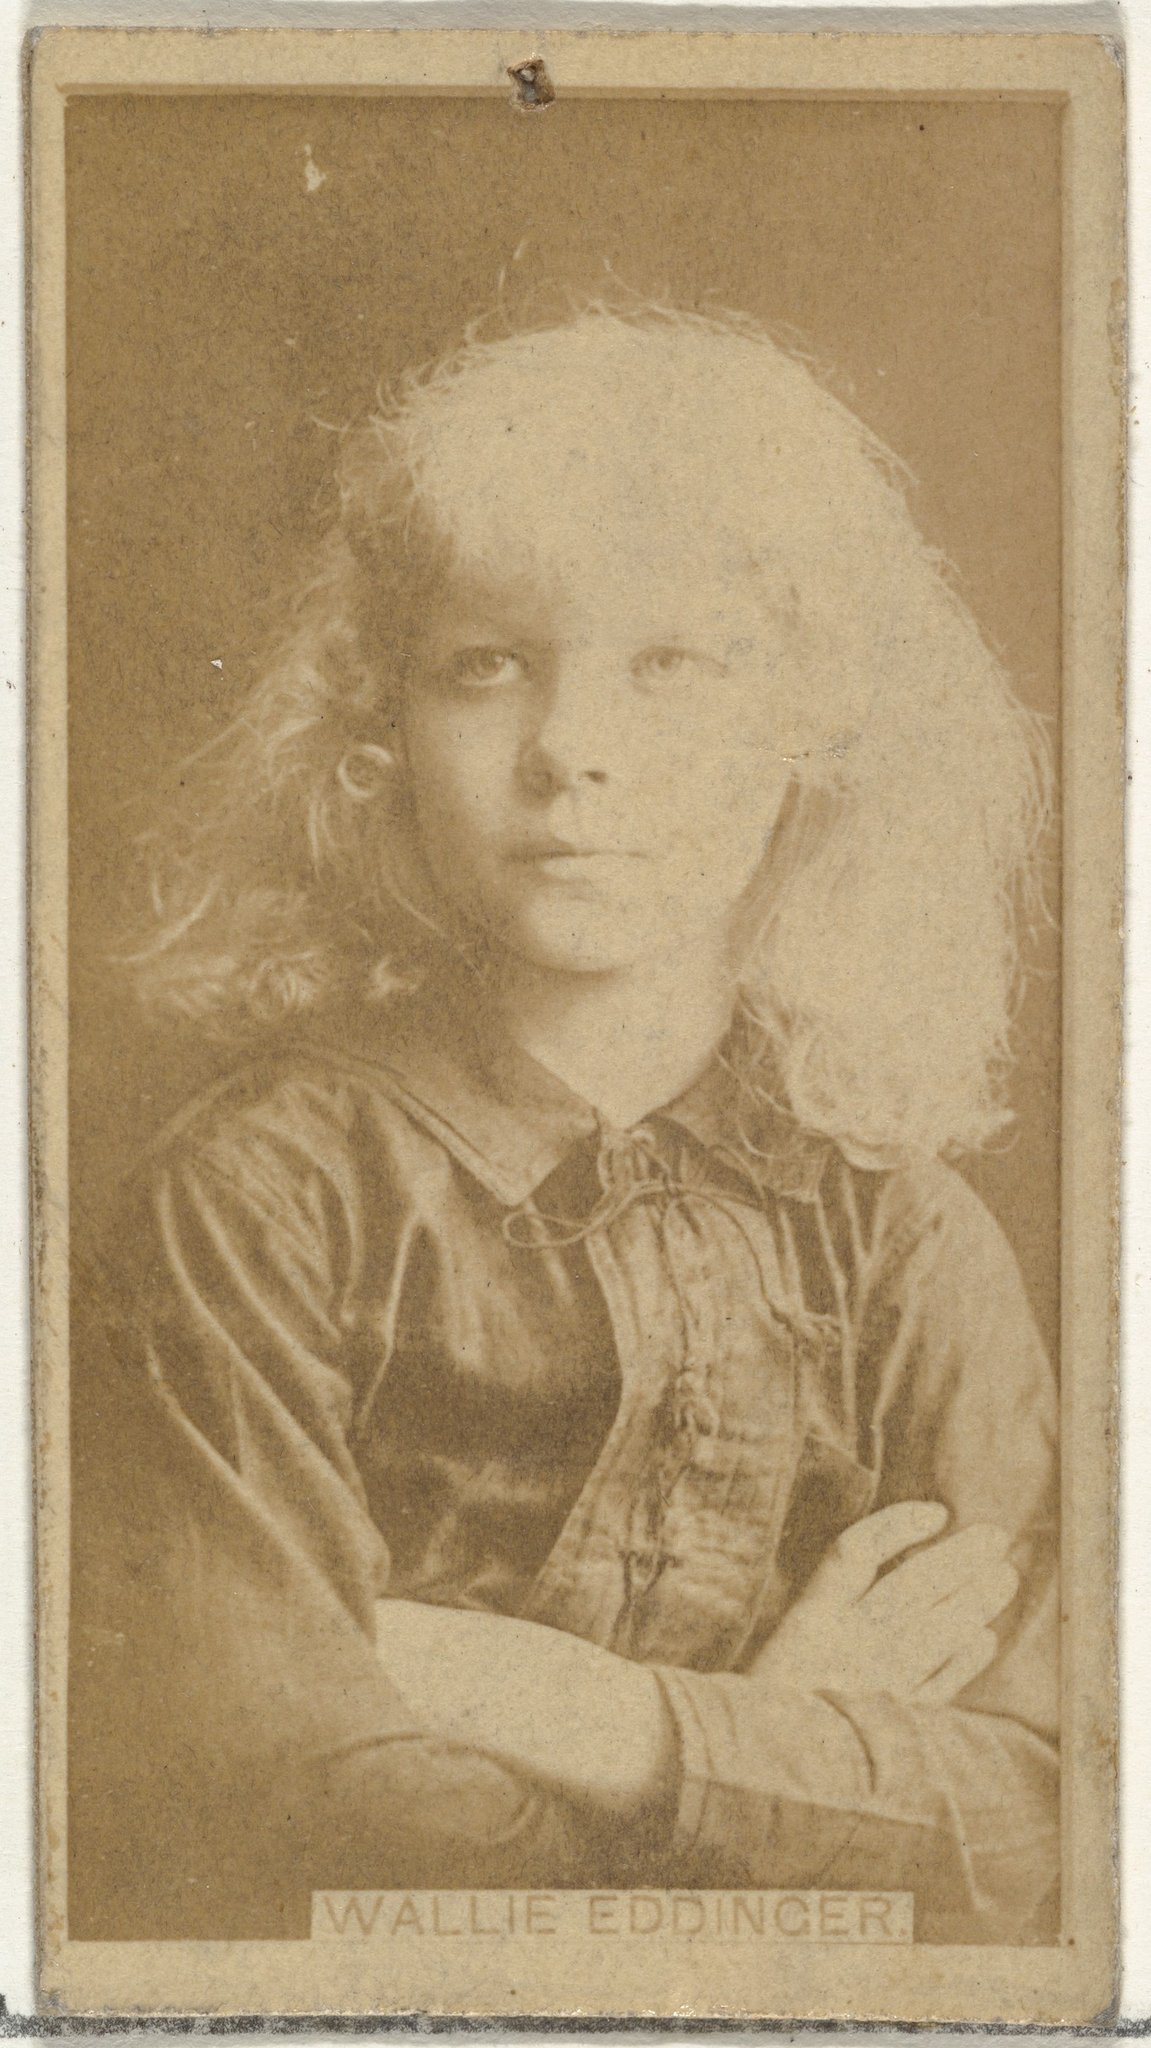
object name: photograph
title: Wallie Eddinger, from the Actors and Actresses series (N145-8) issued by Duke Sons & Co. to promote Duke Cigarettes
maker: w. duke, sons & co.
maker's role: publisher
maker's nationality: american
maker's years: 1870-1920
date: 1891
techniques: albumen silver print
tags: children,portraits,actors